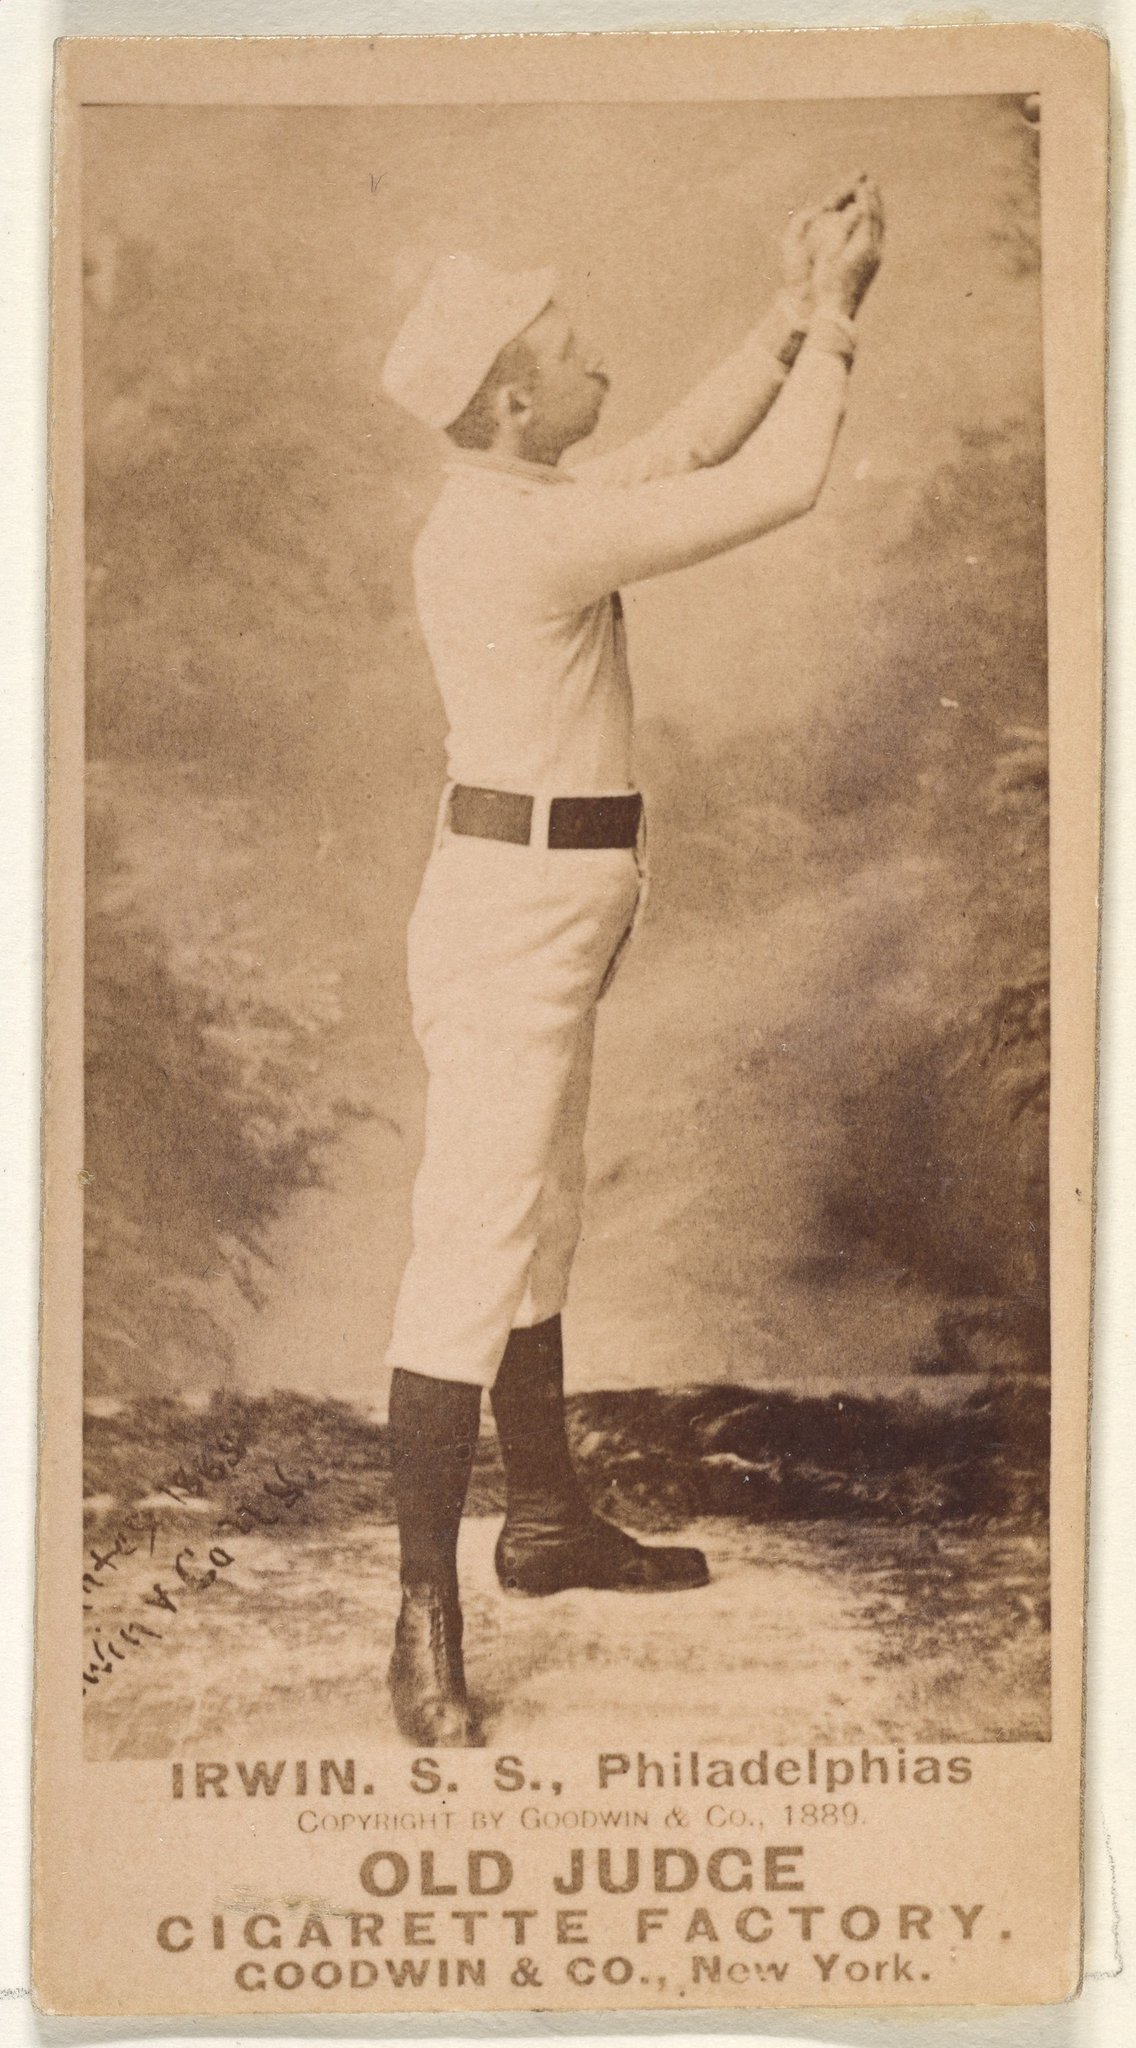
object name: baseball card, photograph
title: Arthur Albert "Doc" Irwin, Shortstop, Philadelphia, from the Old Judge series (N172) for Old Judge Cigarettes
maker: goodwin & company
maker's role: publisher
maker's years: 1850-1950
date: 1889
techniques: albumen silver print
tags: men,baseball,athletes